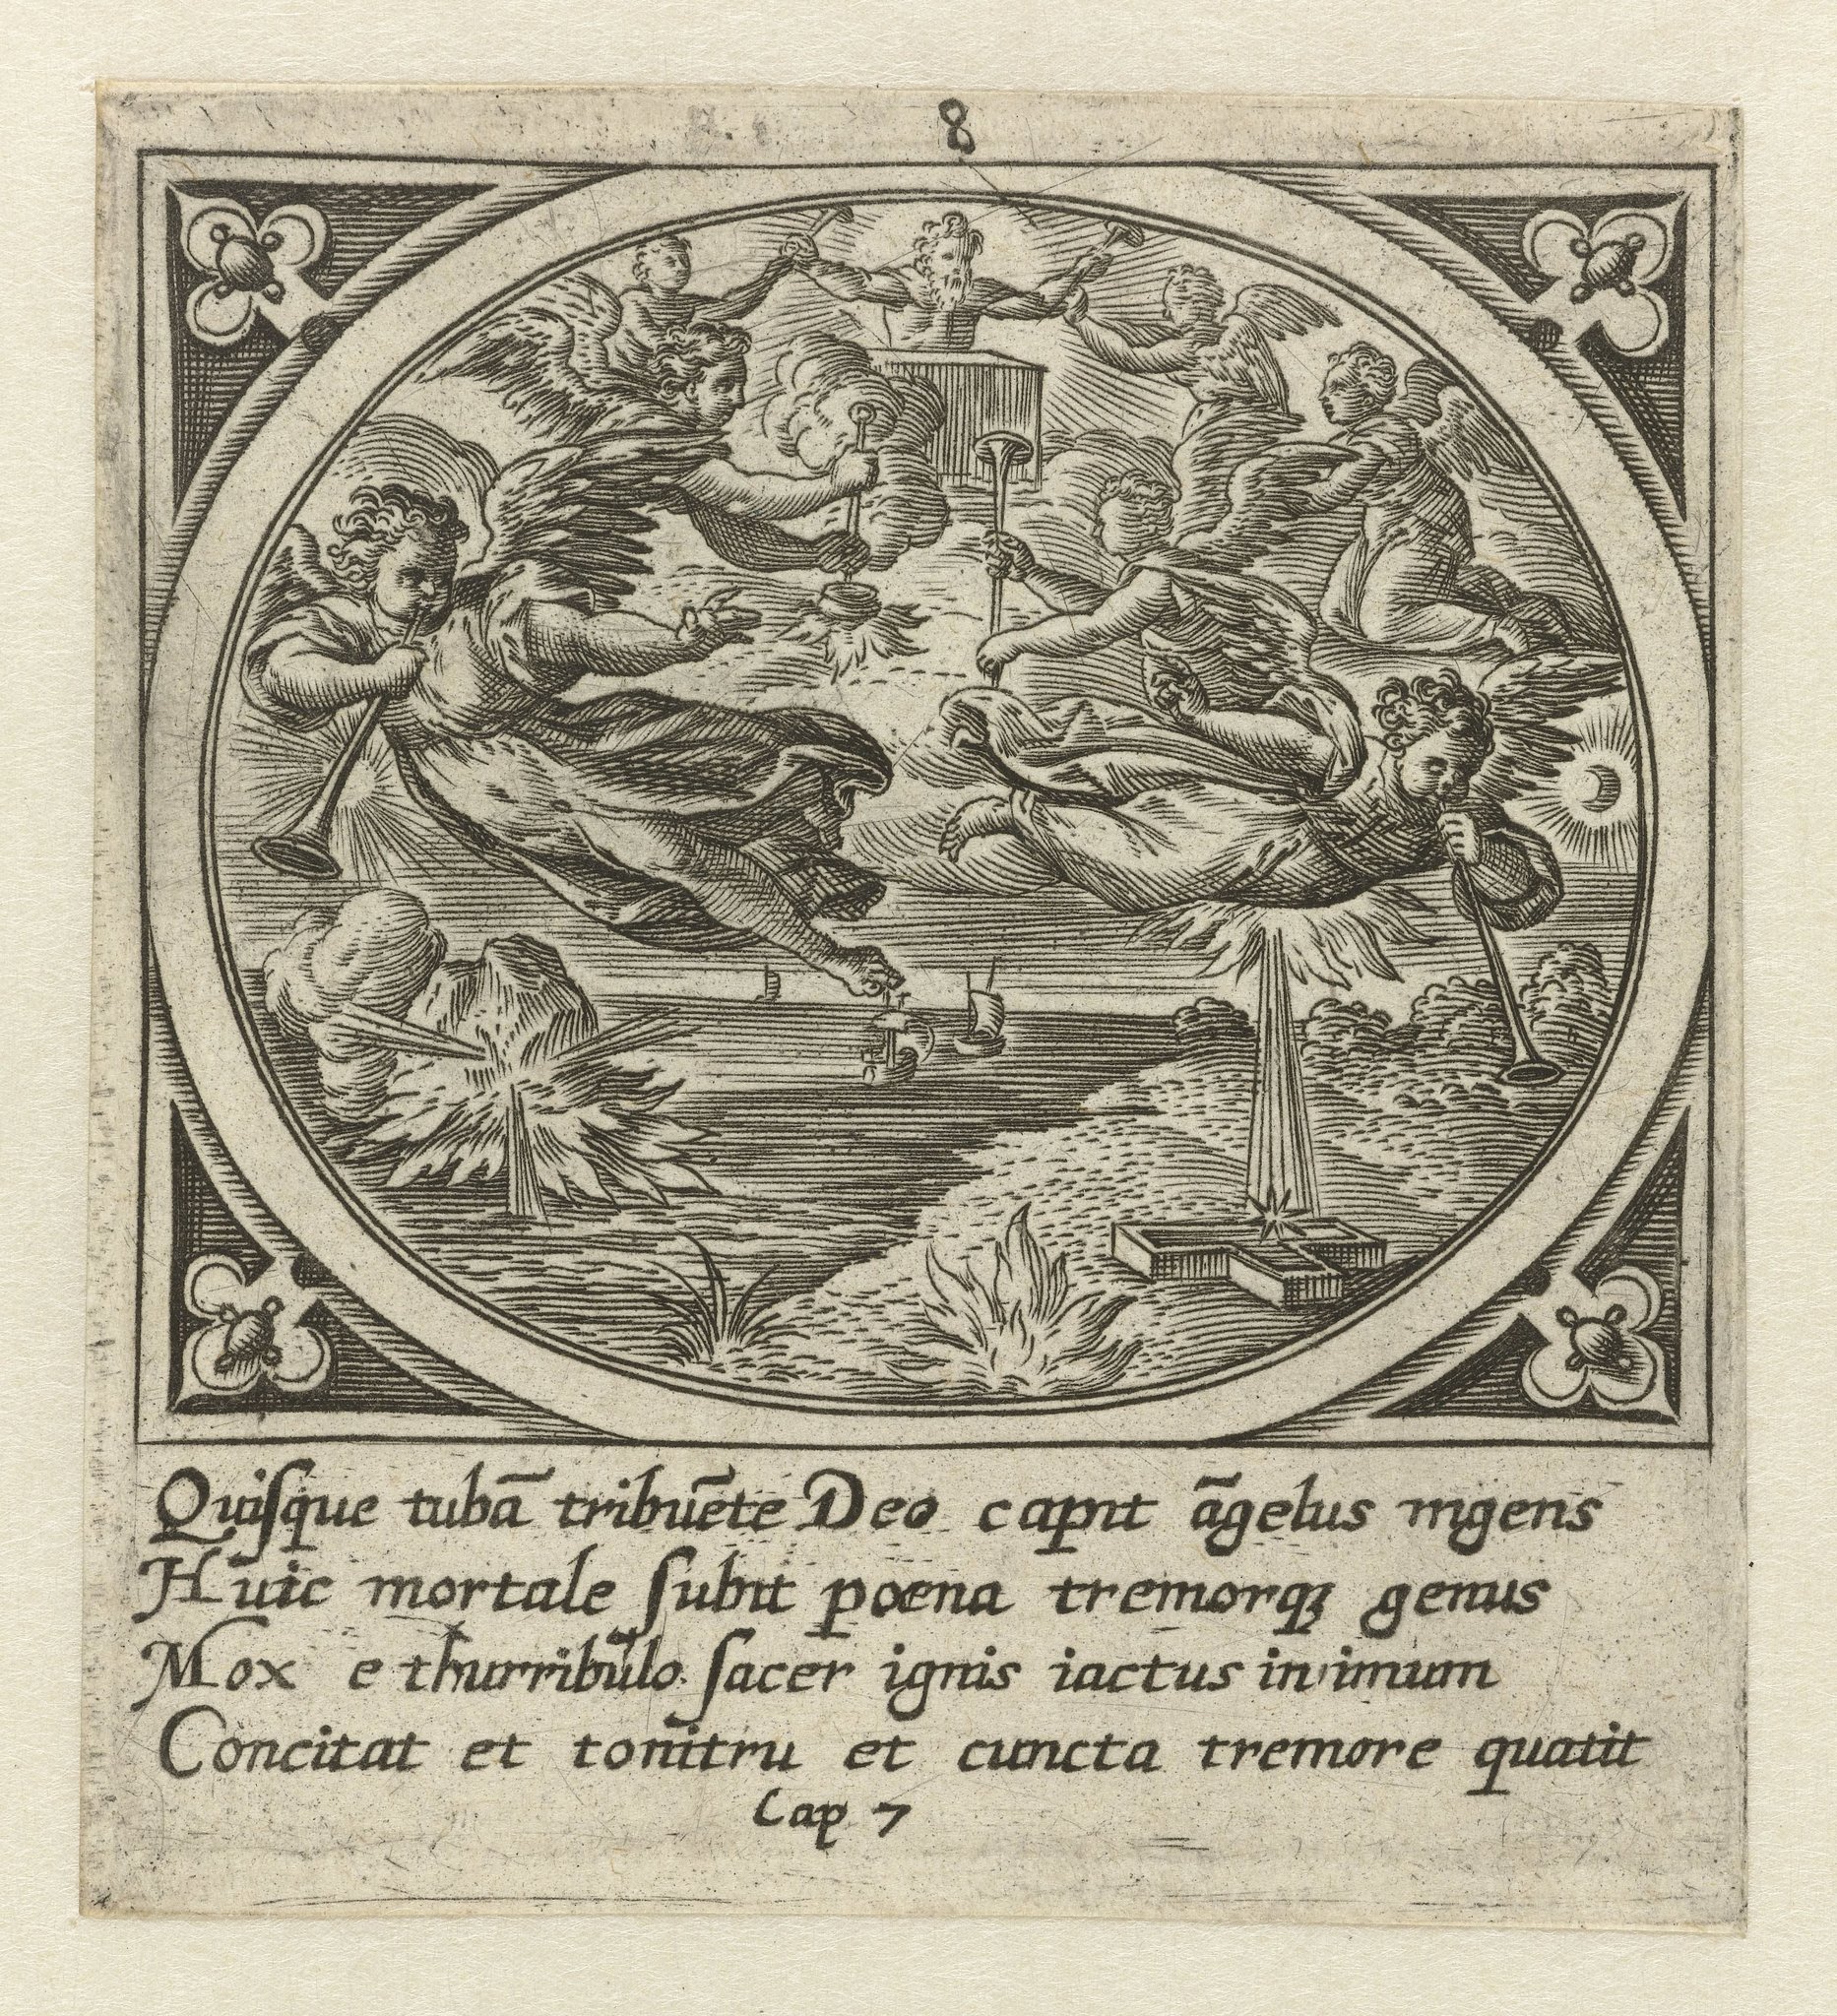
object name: print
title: Zeven engelen krijgen een bazuin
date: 1585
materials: paper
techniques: engraving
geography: antwerp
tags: the seven angels with trumpets ~ revelation of john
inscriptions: collector's mark: Lugt 2760, collector's mark: Lugt 2228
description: Het openen van het zevende zegel: in de wolken God de Vader en zeven engelen met een bazuin. Onder hen de aarde waarop bliksemschichten neerkomen. In de marge een vierregelig onderschrift in het Latijn. Achtste prent uit een serie van vierentwintig met de openbaring van Johannes op Patmos.